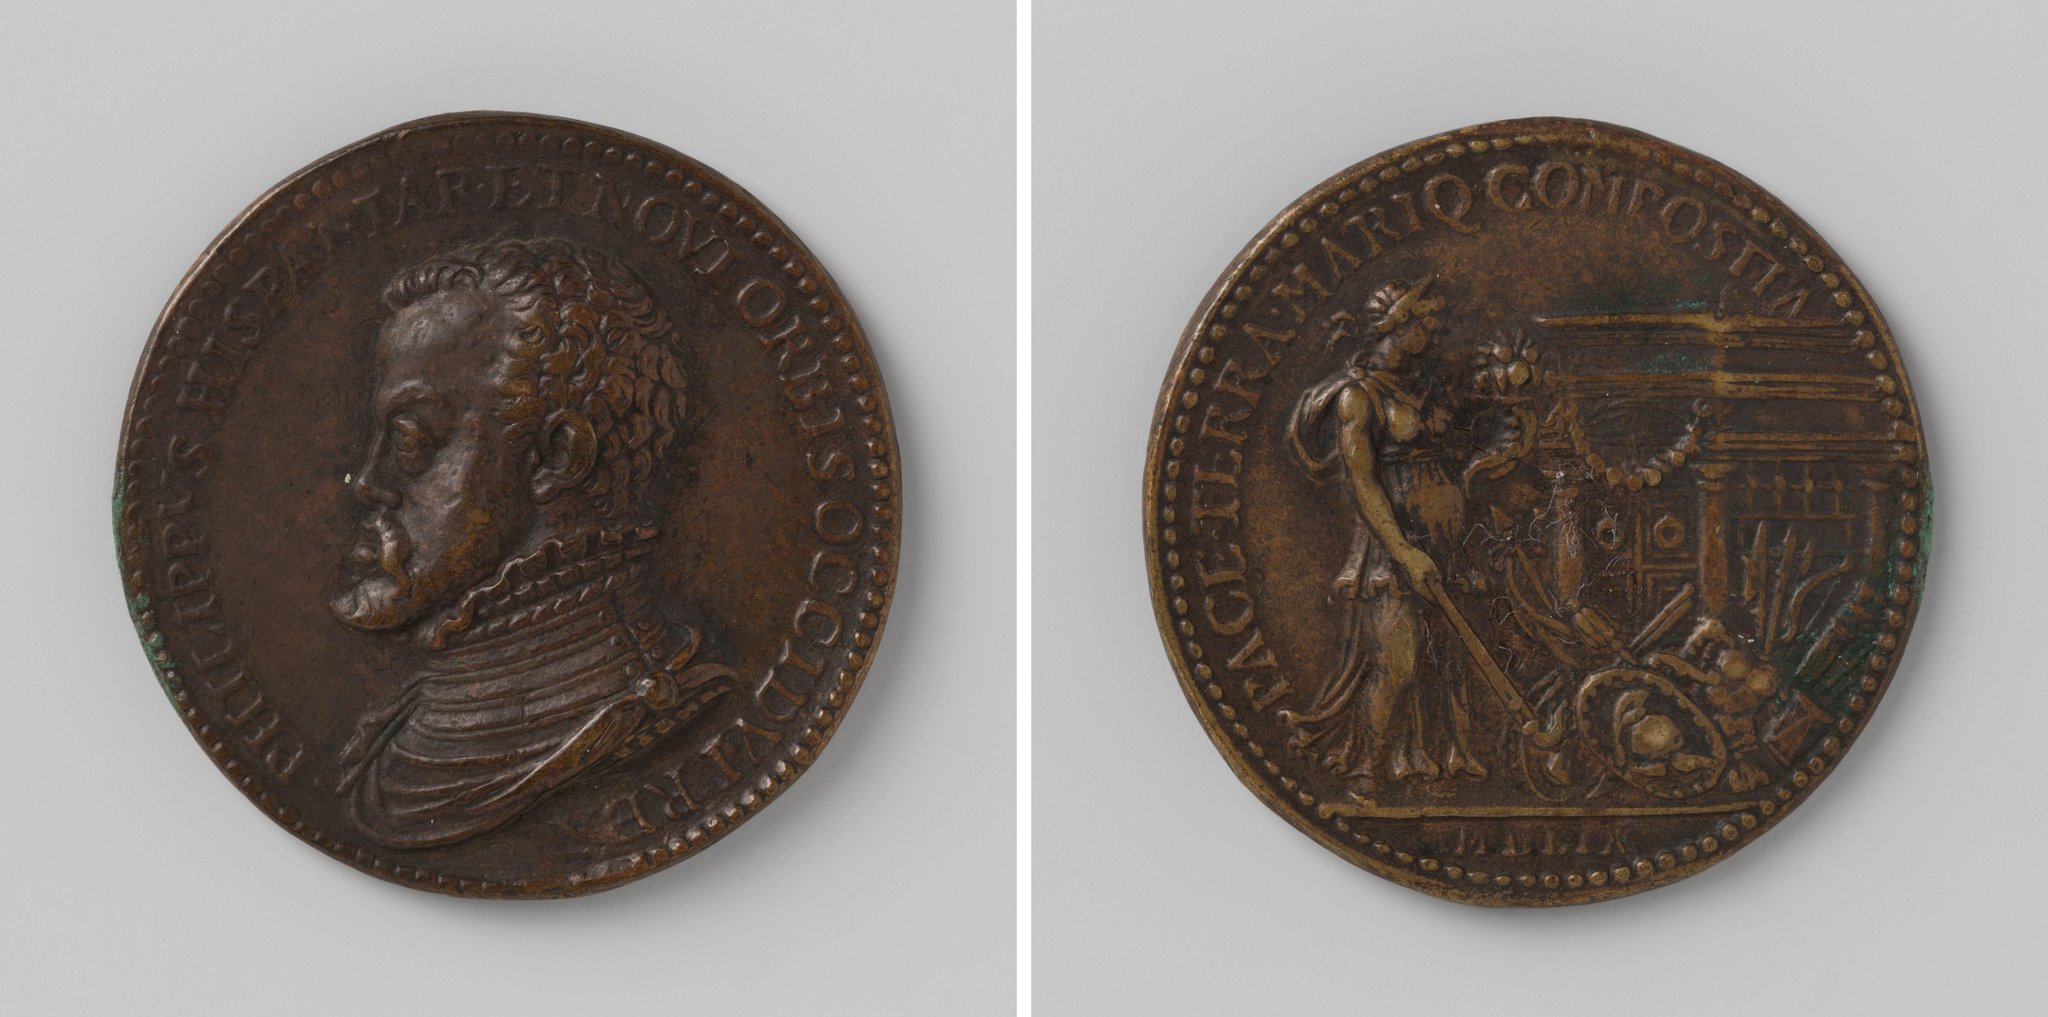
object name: history medal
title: Vrede van Le Cateau-Cambresis, ter ere van Filips II van Spanje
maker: gianpaolo poggini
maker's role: medailleur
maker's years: 1518-1582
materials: bronze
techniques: casting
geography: madrid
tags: philip ii of spain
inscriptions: circumscription: ‘PACE TERRA MARIQ COMPOSITA / MDLIX’, circumscription: ‘PHILIPPVS HISPANIAR ET NOVI ORBIS OCCIDVI REX’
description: Bronzen penning. Voorzijde: borststuk man binnen omschrift. Keerzijde: staande voor tempel van Janus, steekt Vrede met in hand hoorn van overvloed stapel krijgstuig in brand binnen omschrift; afsnede: jaartal